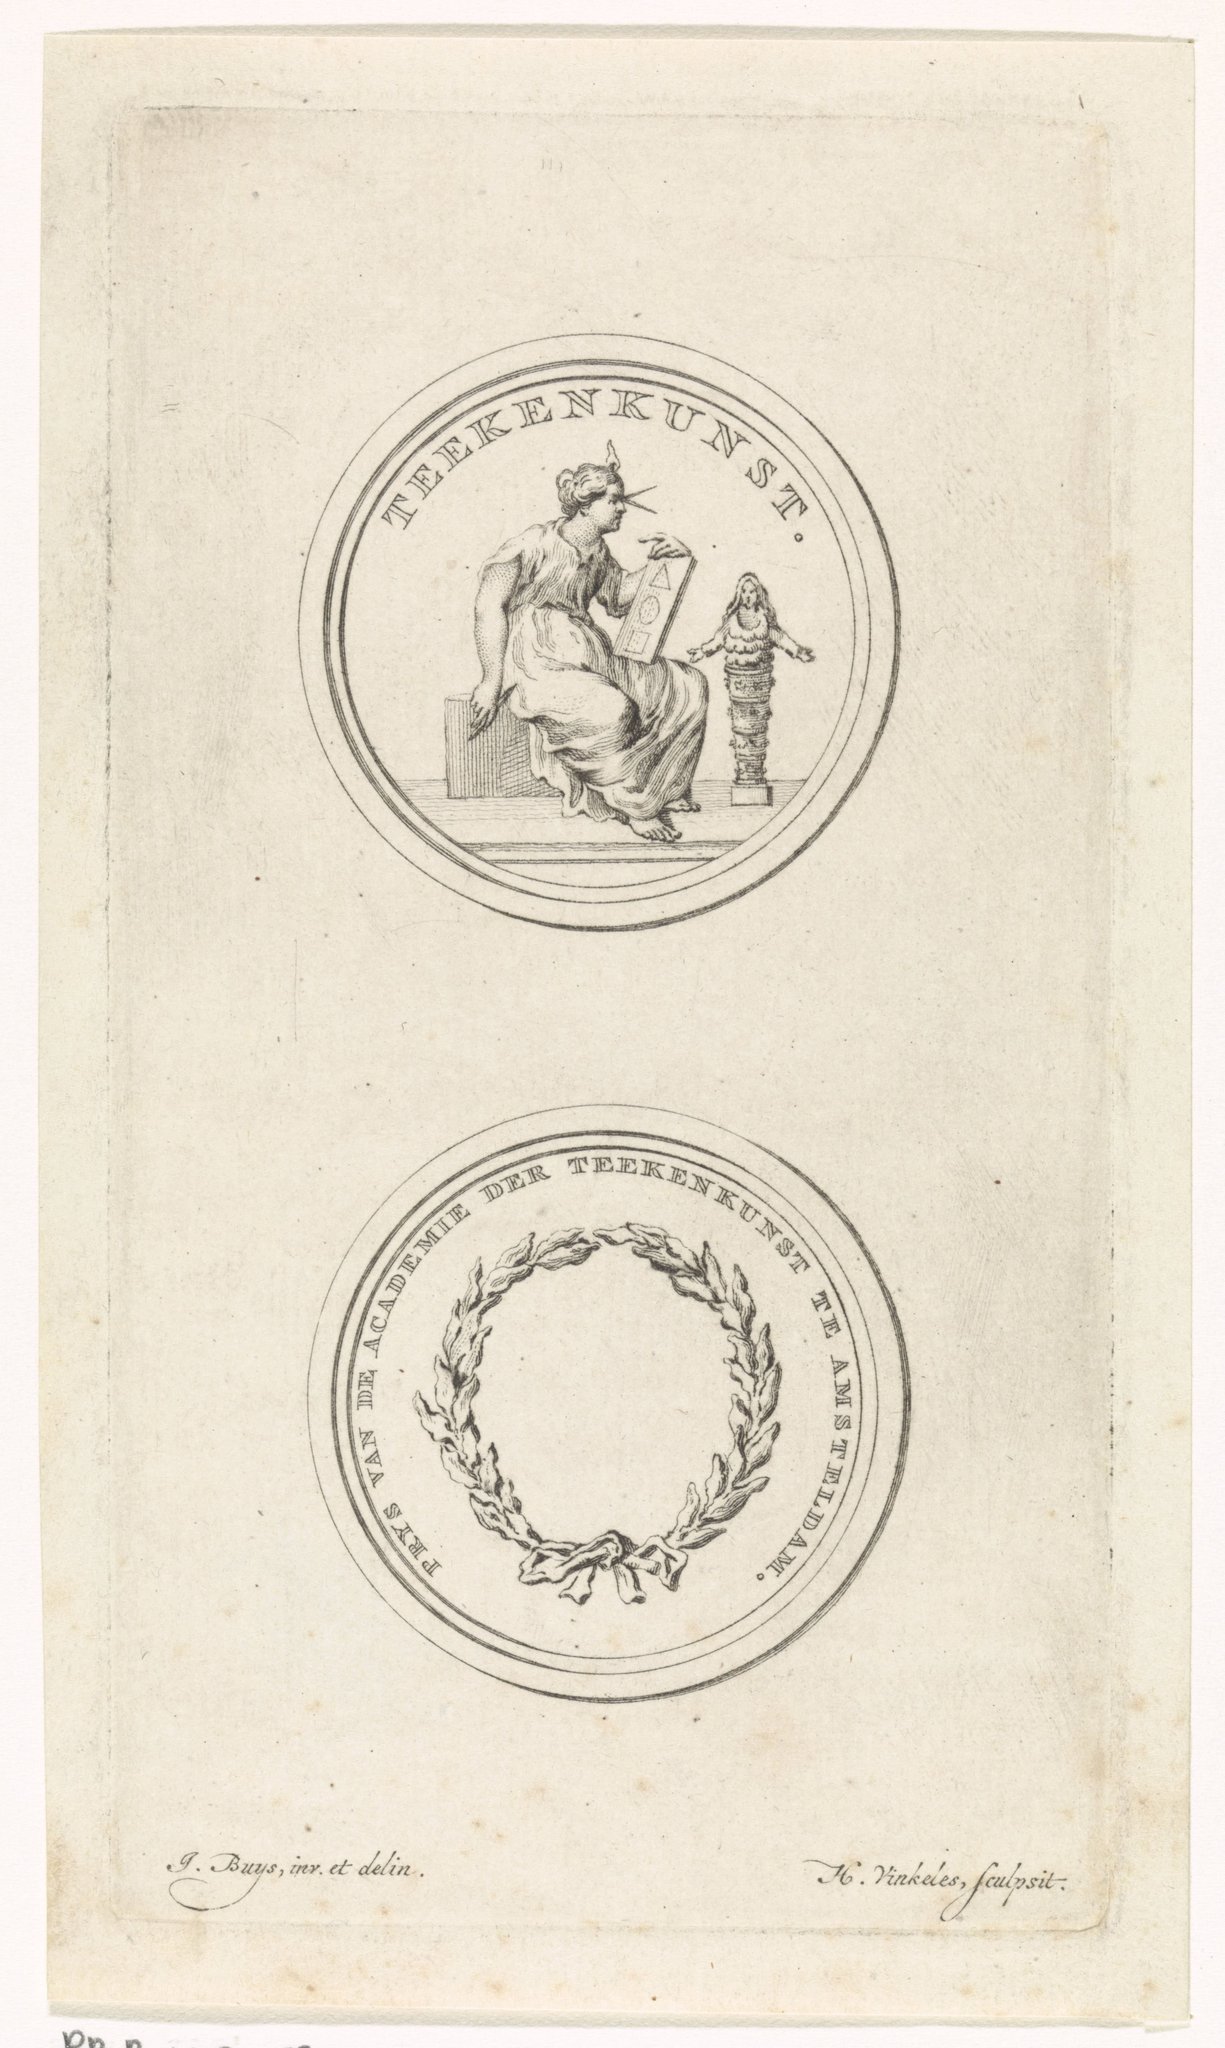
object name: print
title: Voor- en achterzijde van medaille van de academie der tekenkunst te Amsterdam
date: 1765-1800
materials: paper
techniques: engraving, etching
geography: amsterdam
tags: honouring the artist with laurel wreath (+ variant), memorial medal, compasses, symbolic representations, allegories and emblems ~ drawing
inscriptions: collector's mark: Lugt 2228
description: Tekenkunst, afgebeeld als vrouw met vlam op hoofd, zit met pen en tekenbord in handen op steen tegenover een beeld, dat zij met passer in haar oog opmeet, binnen omschrift. Keerzijde: opschrift binnen lauwerkrans en omschrift.